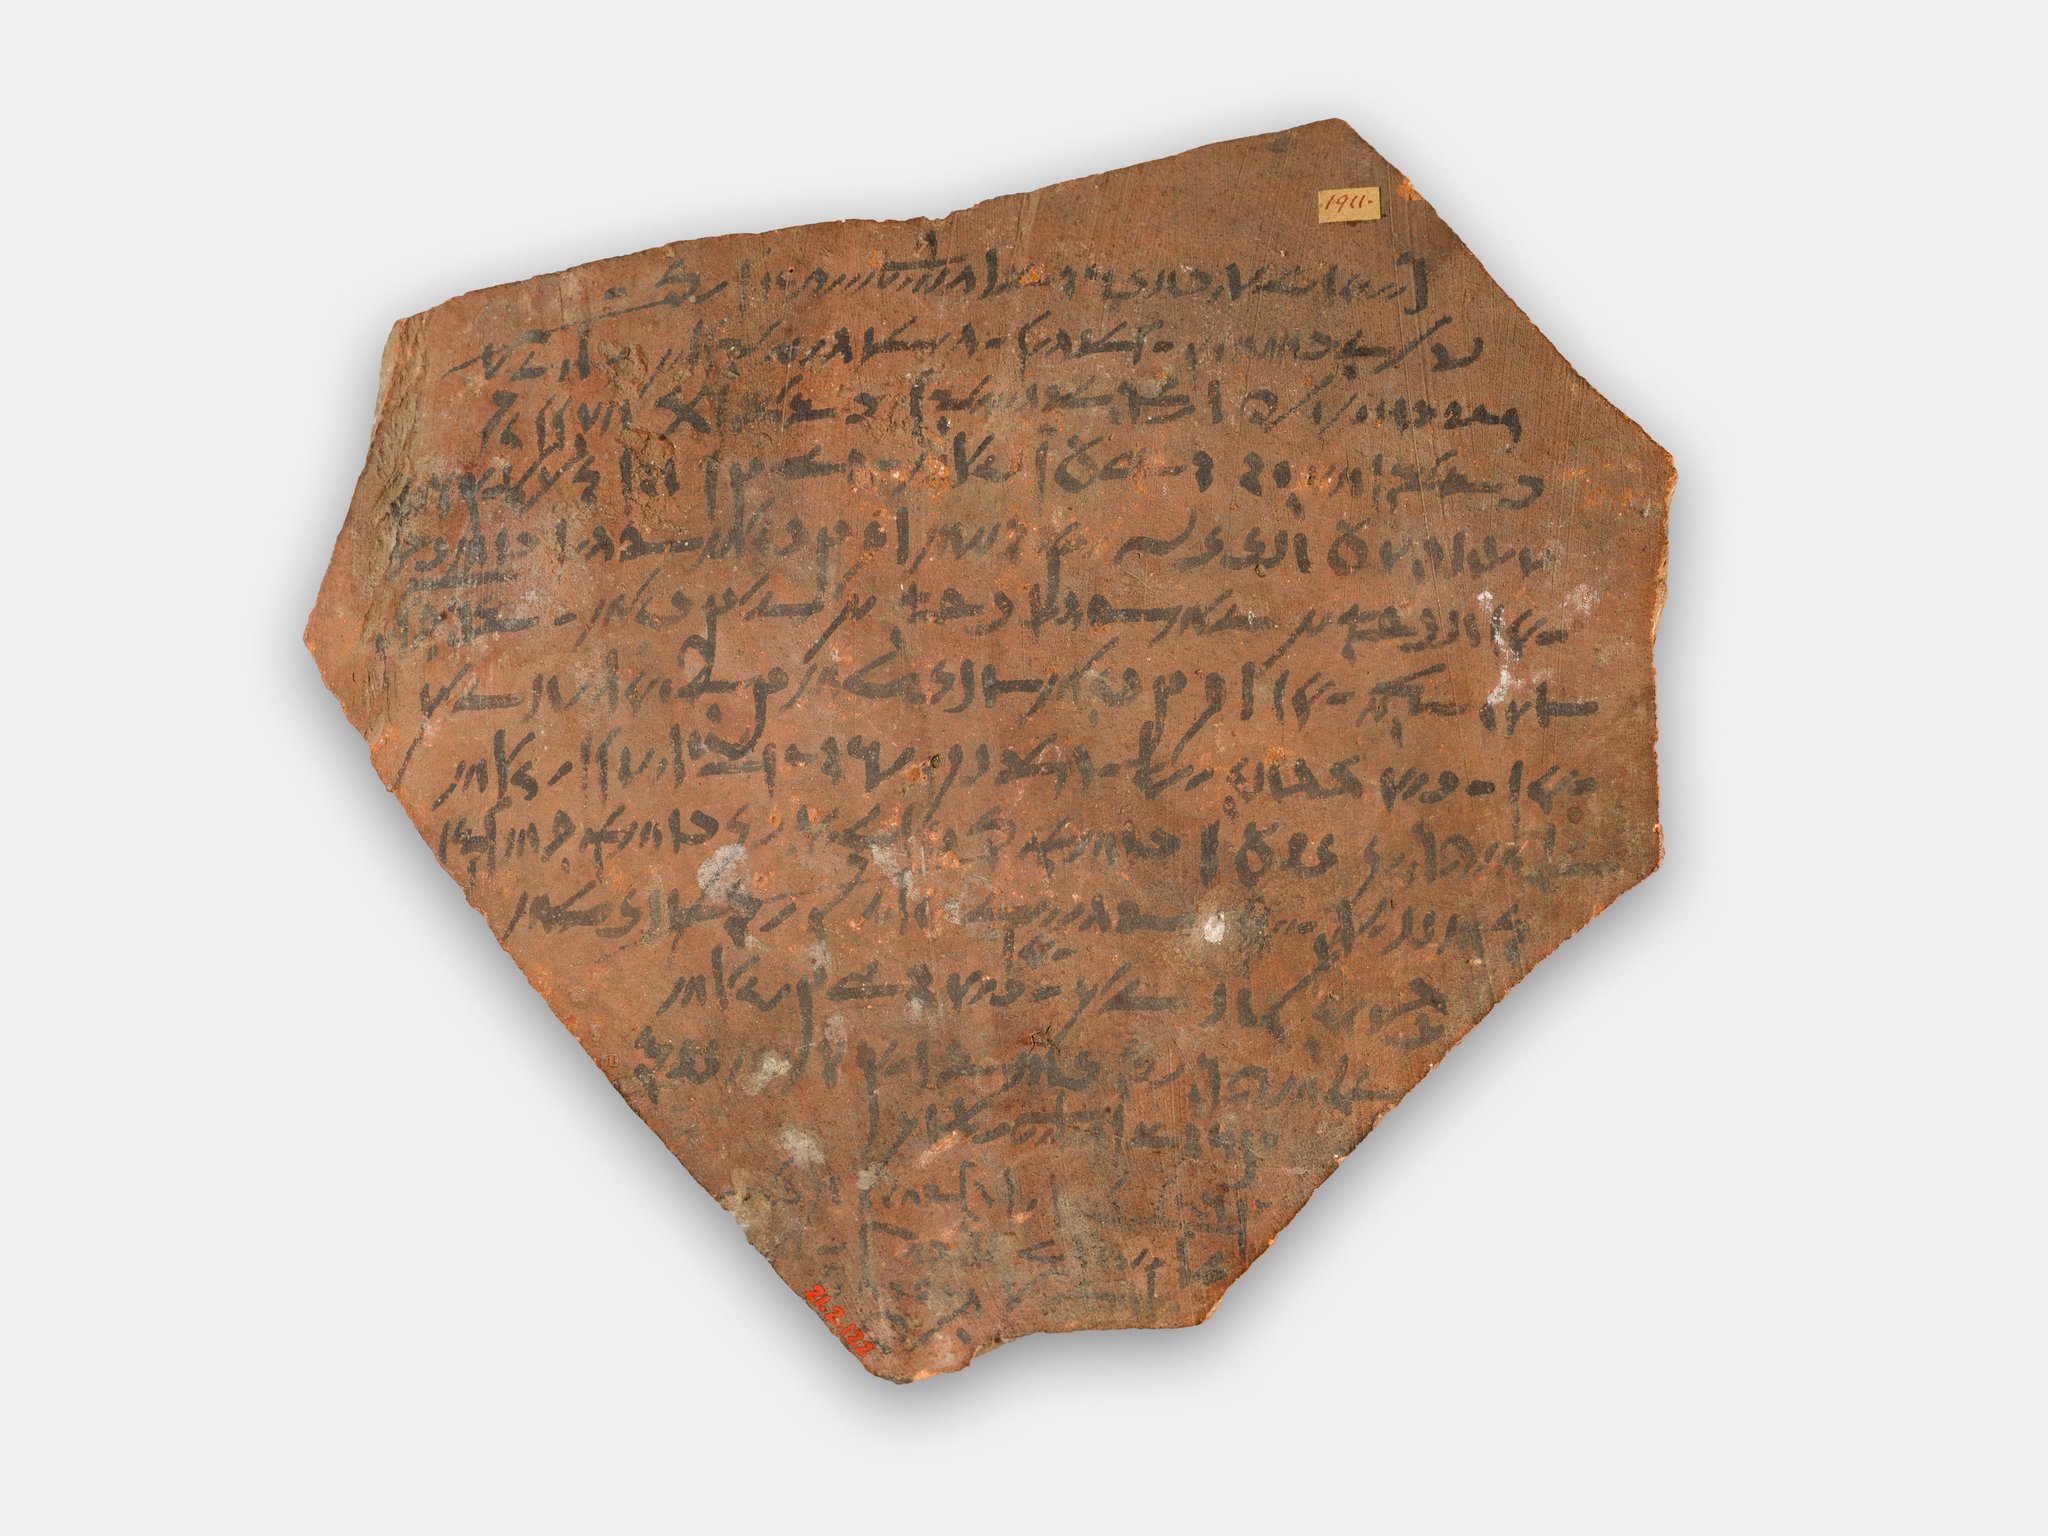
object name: ostracon, demotic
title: Demotic Temple Oath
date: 127 BCE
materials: ink, pottery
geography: southern upper egypt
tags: demotic